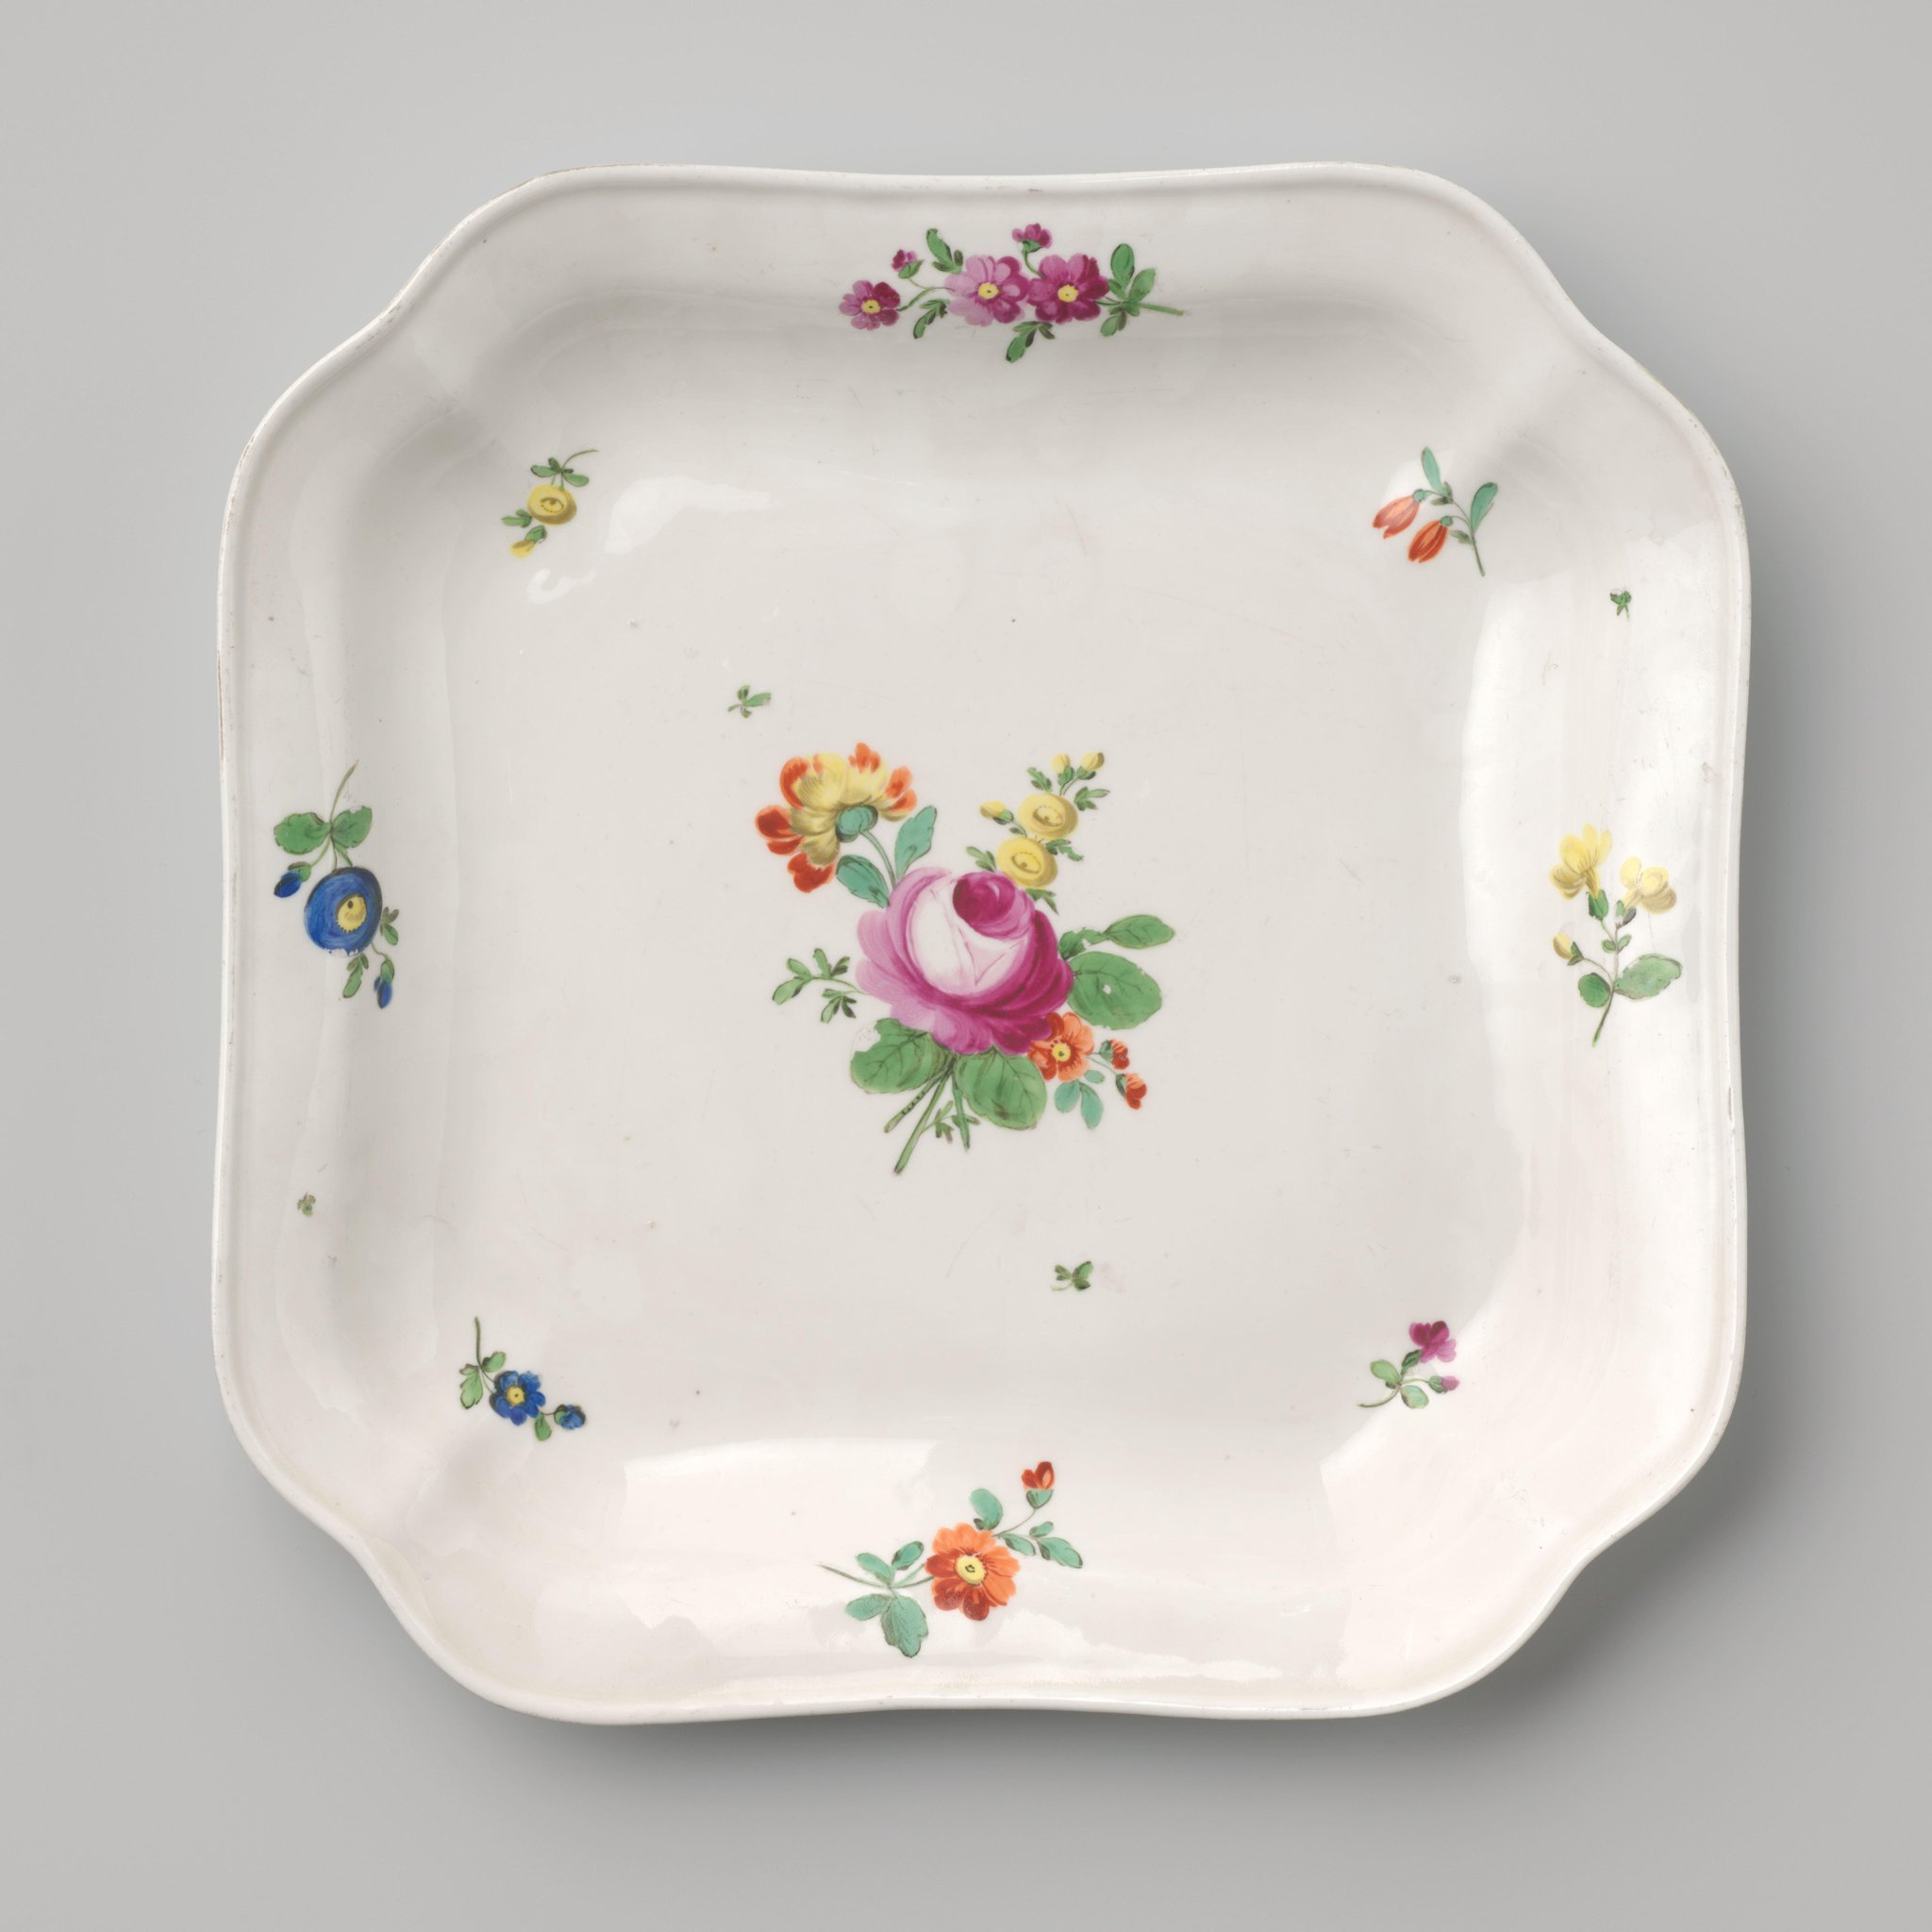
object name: service set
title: Dish with a bouquet and flower sprays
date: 1800-1849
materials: glaze, paint, porcelain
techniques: firing, forming, turning, vitrification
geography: vienna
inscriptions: mark: ‘schild/ S/ P56/ C/ 88’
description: Vierkante schaal van porselein met geknepen hoeken en gelobde wand en rand, beschilderd op het glazuur in rood, roze, groen en geel. Op het plat een boeket van verschillende bloemen (o.a. pioenroos) omgeven door losse takjes en bloemtakken. Gemerkt op de onderzijde met het schild, de letter S, P56, C en nummer 88.